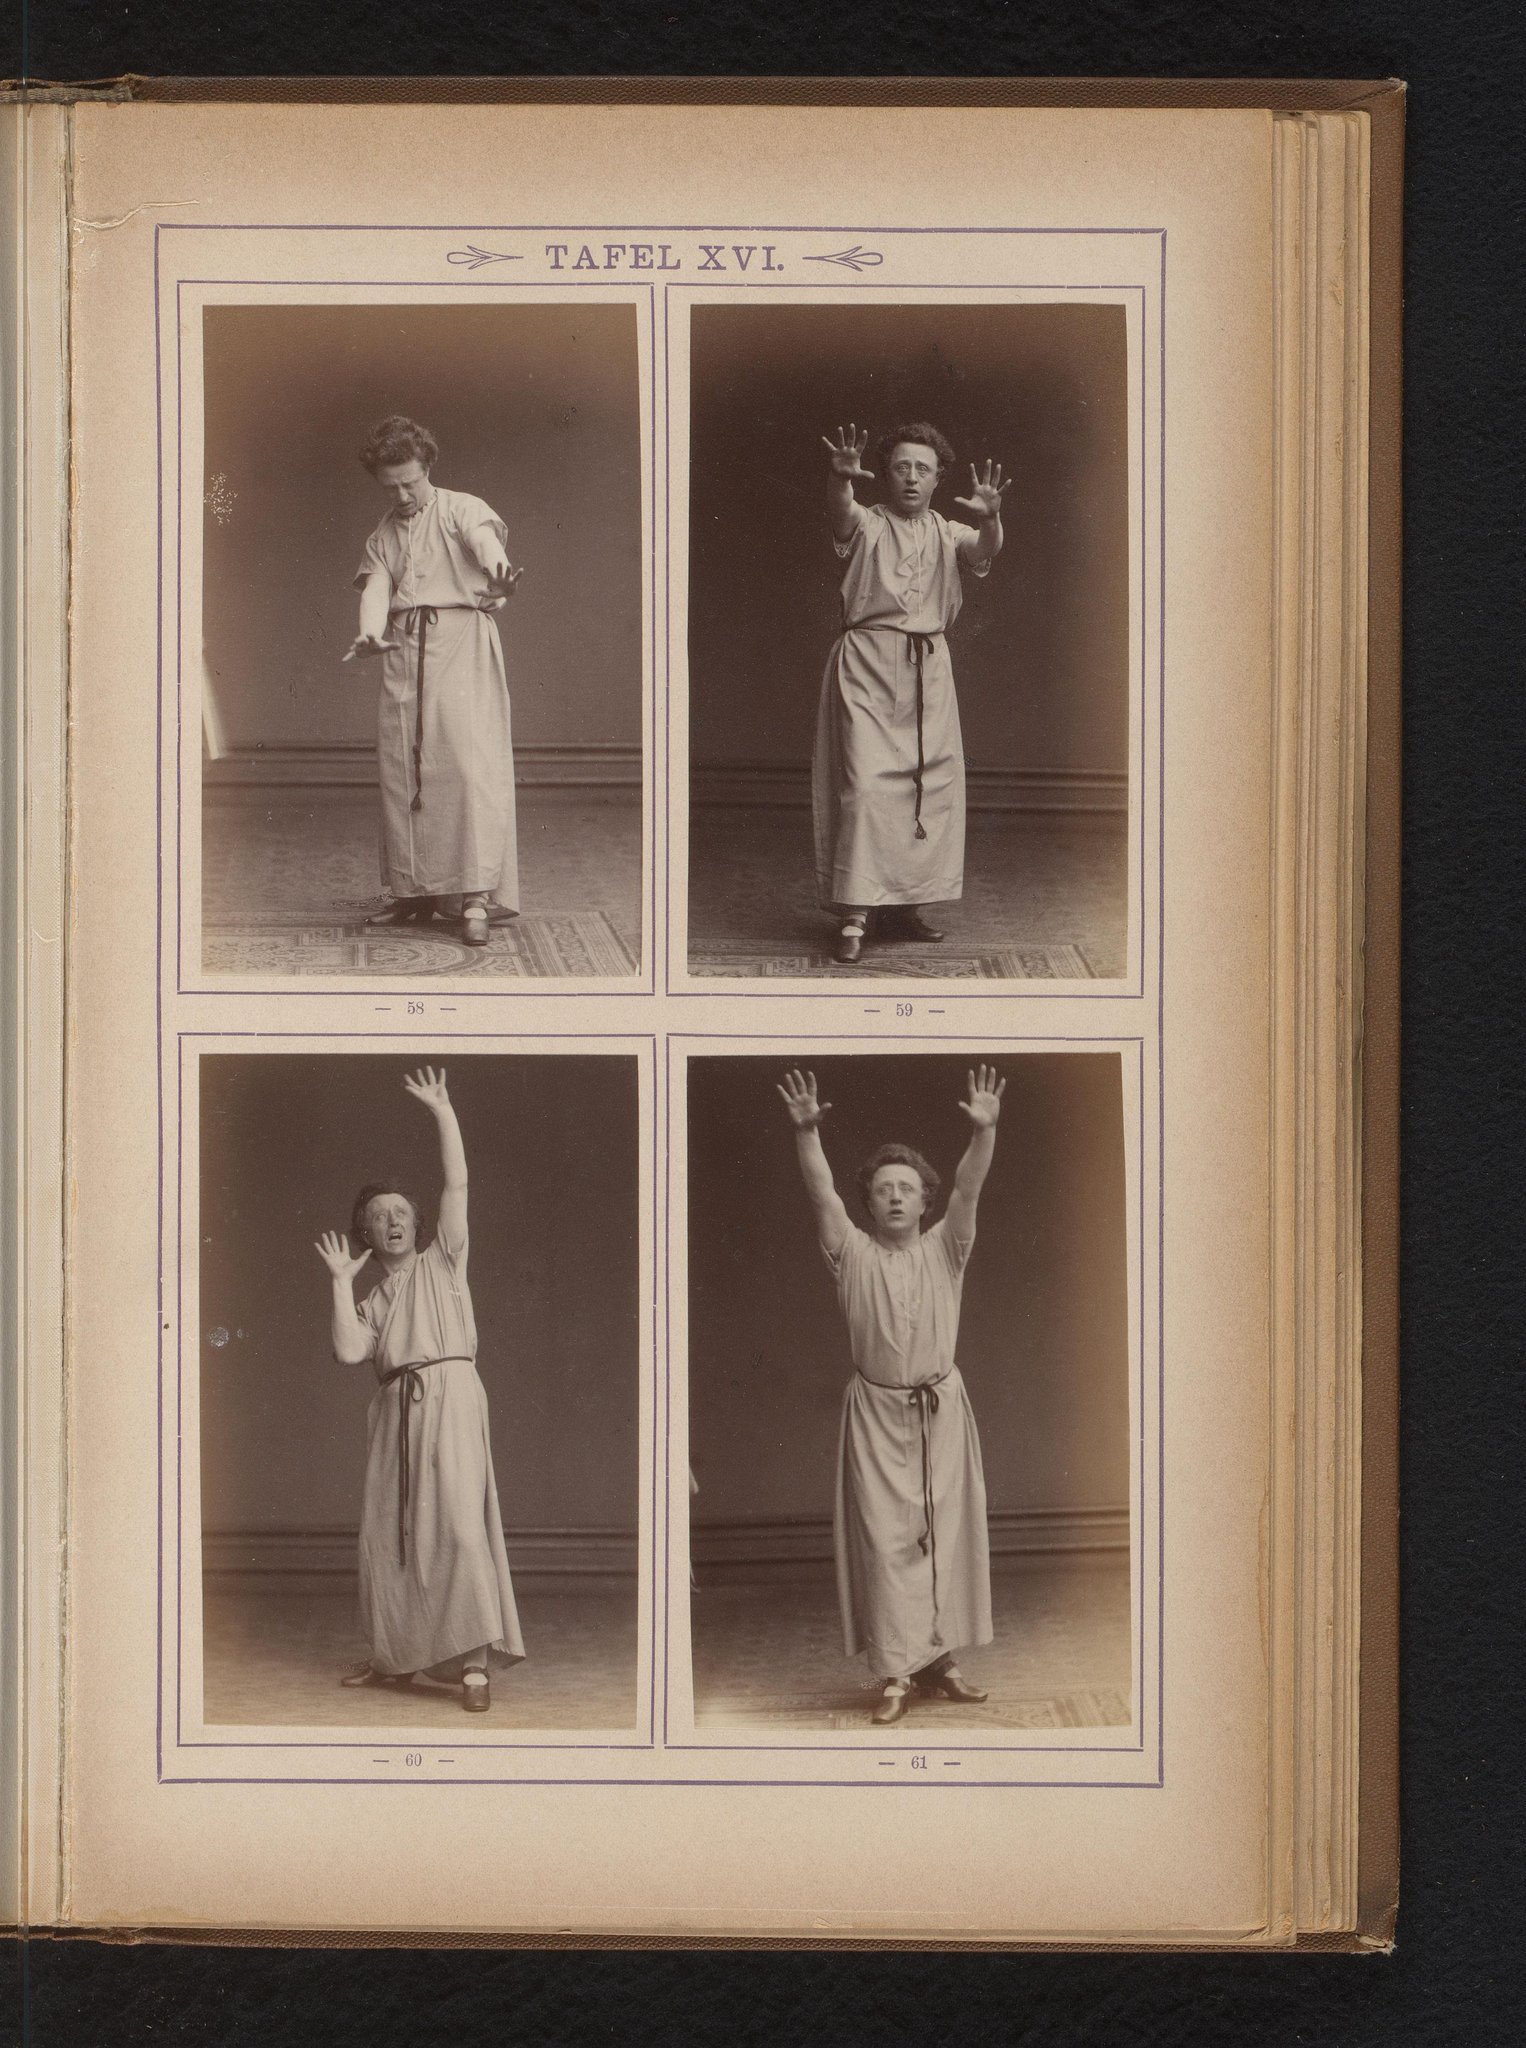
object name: photograph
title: Portretten van een man in vier poses met gestrekte armen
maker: nicola tonger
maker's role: fotograaf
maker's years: 1846-1917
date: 1881-1886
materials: paper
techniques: albumen print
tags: gesture-language, arm raised upward, arm stretched sidewards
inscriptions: number: ‘TAFEL XVI.’, number: ‘58 - 61’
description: Foto op eenendertigste ongenummerde pagina na pagina 6.